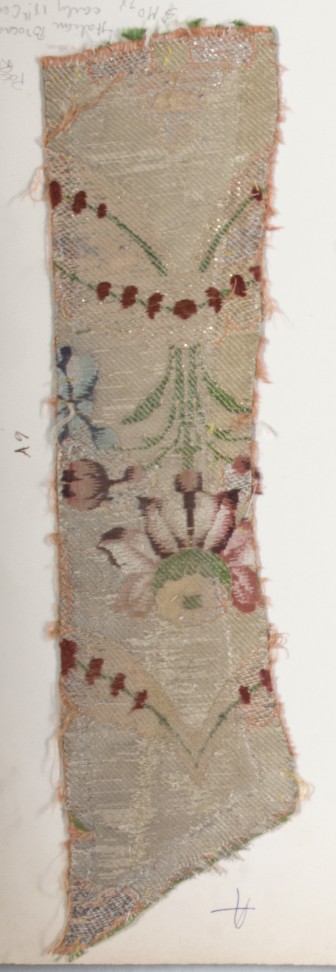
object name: fragment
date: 1701-1733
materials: metal thread, silk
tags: flowers